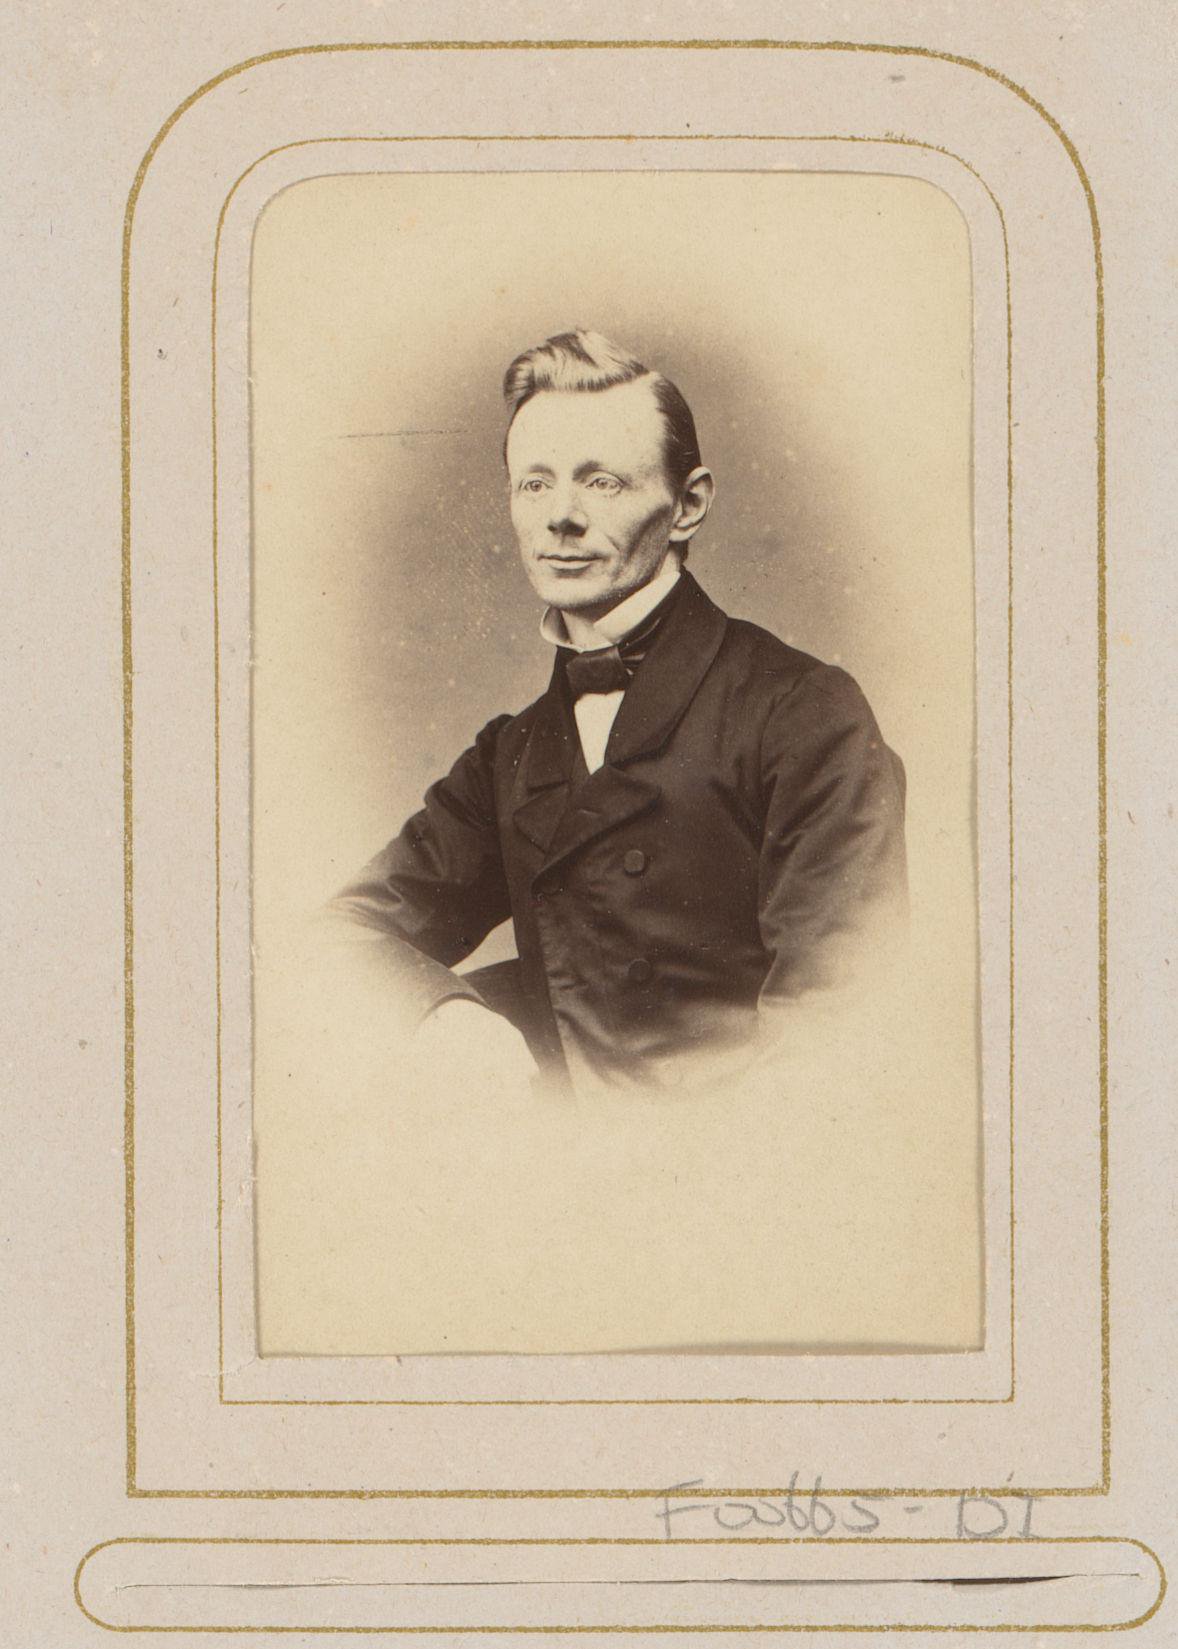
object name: photograph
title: Portret van een man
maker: franz wilhelm deutmann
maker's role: fotograaf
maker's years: 1809-1895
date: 1853-1889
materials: cardboard, photographic support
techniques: albumen print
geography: amsterdam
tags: historical persons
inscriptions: inscription: ‘F.W. Deutmann/ Photograph/ Amsterdam’